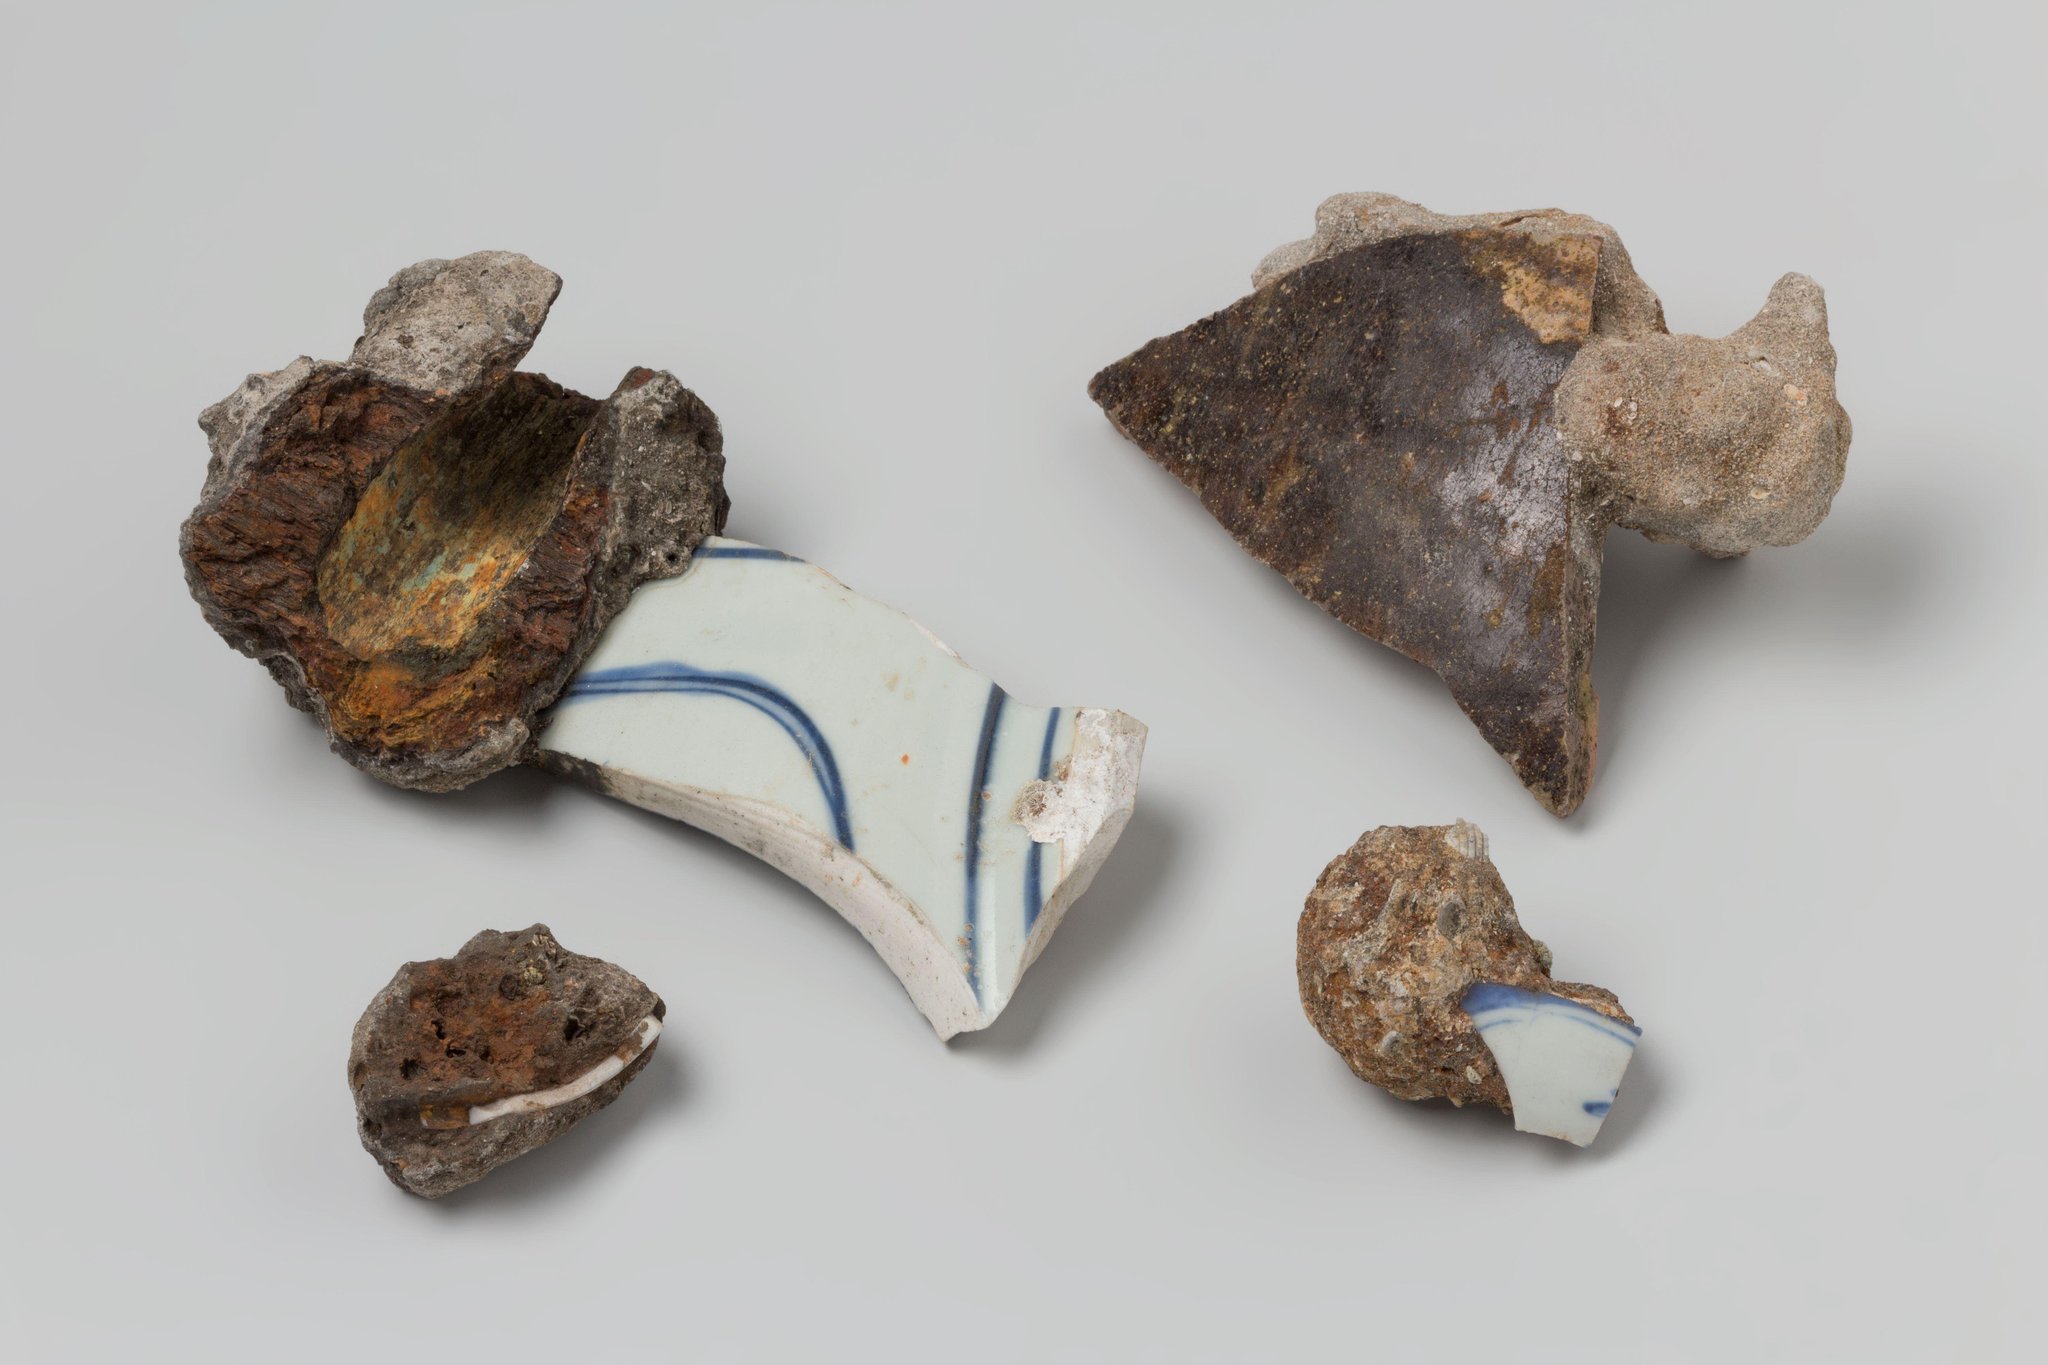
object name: sherd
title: Scherven van steengoed en porselein uit V.O.C.-schip de 'Witte Leeuw'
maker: Anonymous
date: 1613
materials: ceramic, stone, shell, stoneware, glaze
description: Scherven van steengoed (wandscherf) en porselein (wandscherf met deel standring) met aankoeksels van de zeebodem uit V.O.C.-schip de 'Witte Leeuw'.